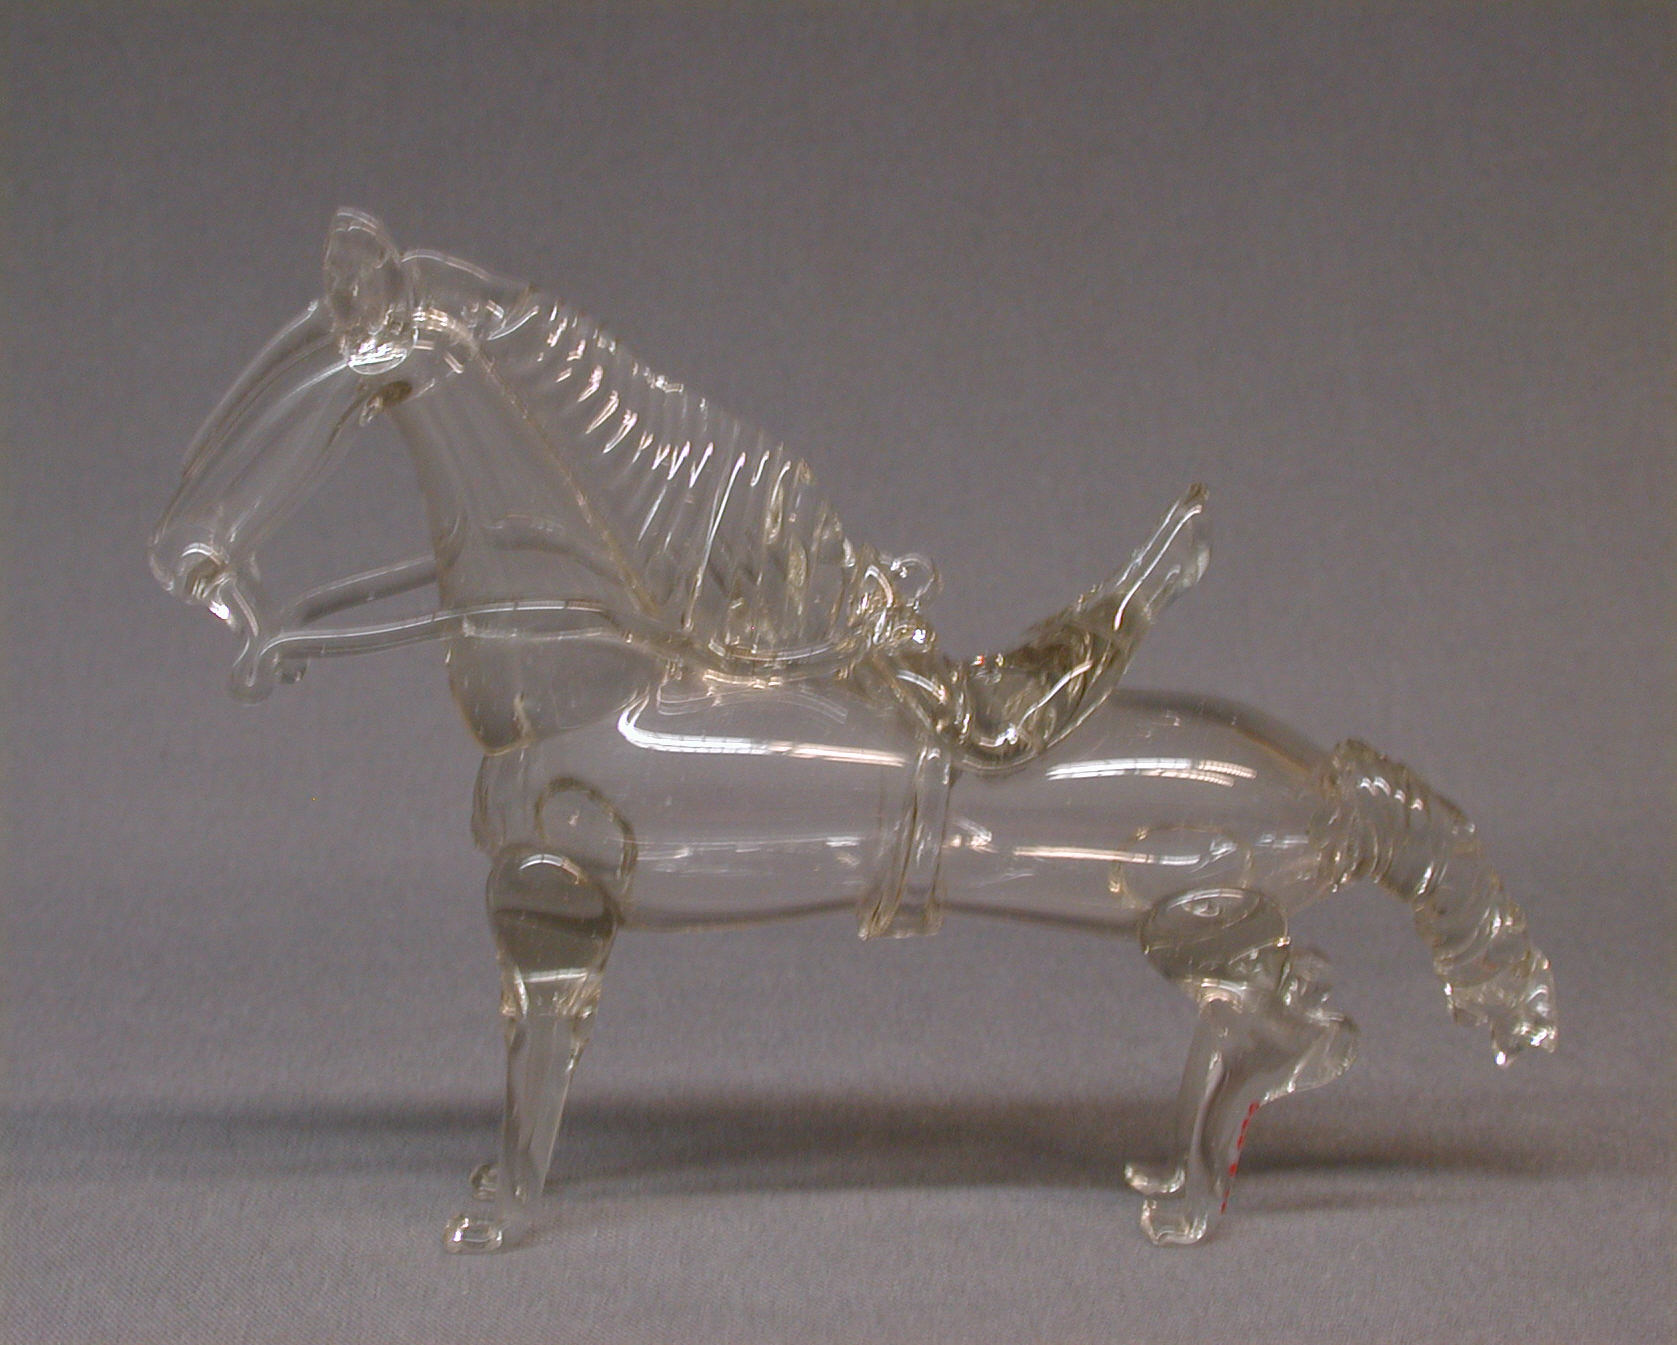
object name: figure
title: Horse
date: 1701-1900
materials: glass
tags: horses